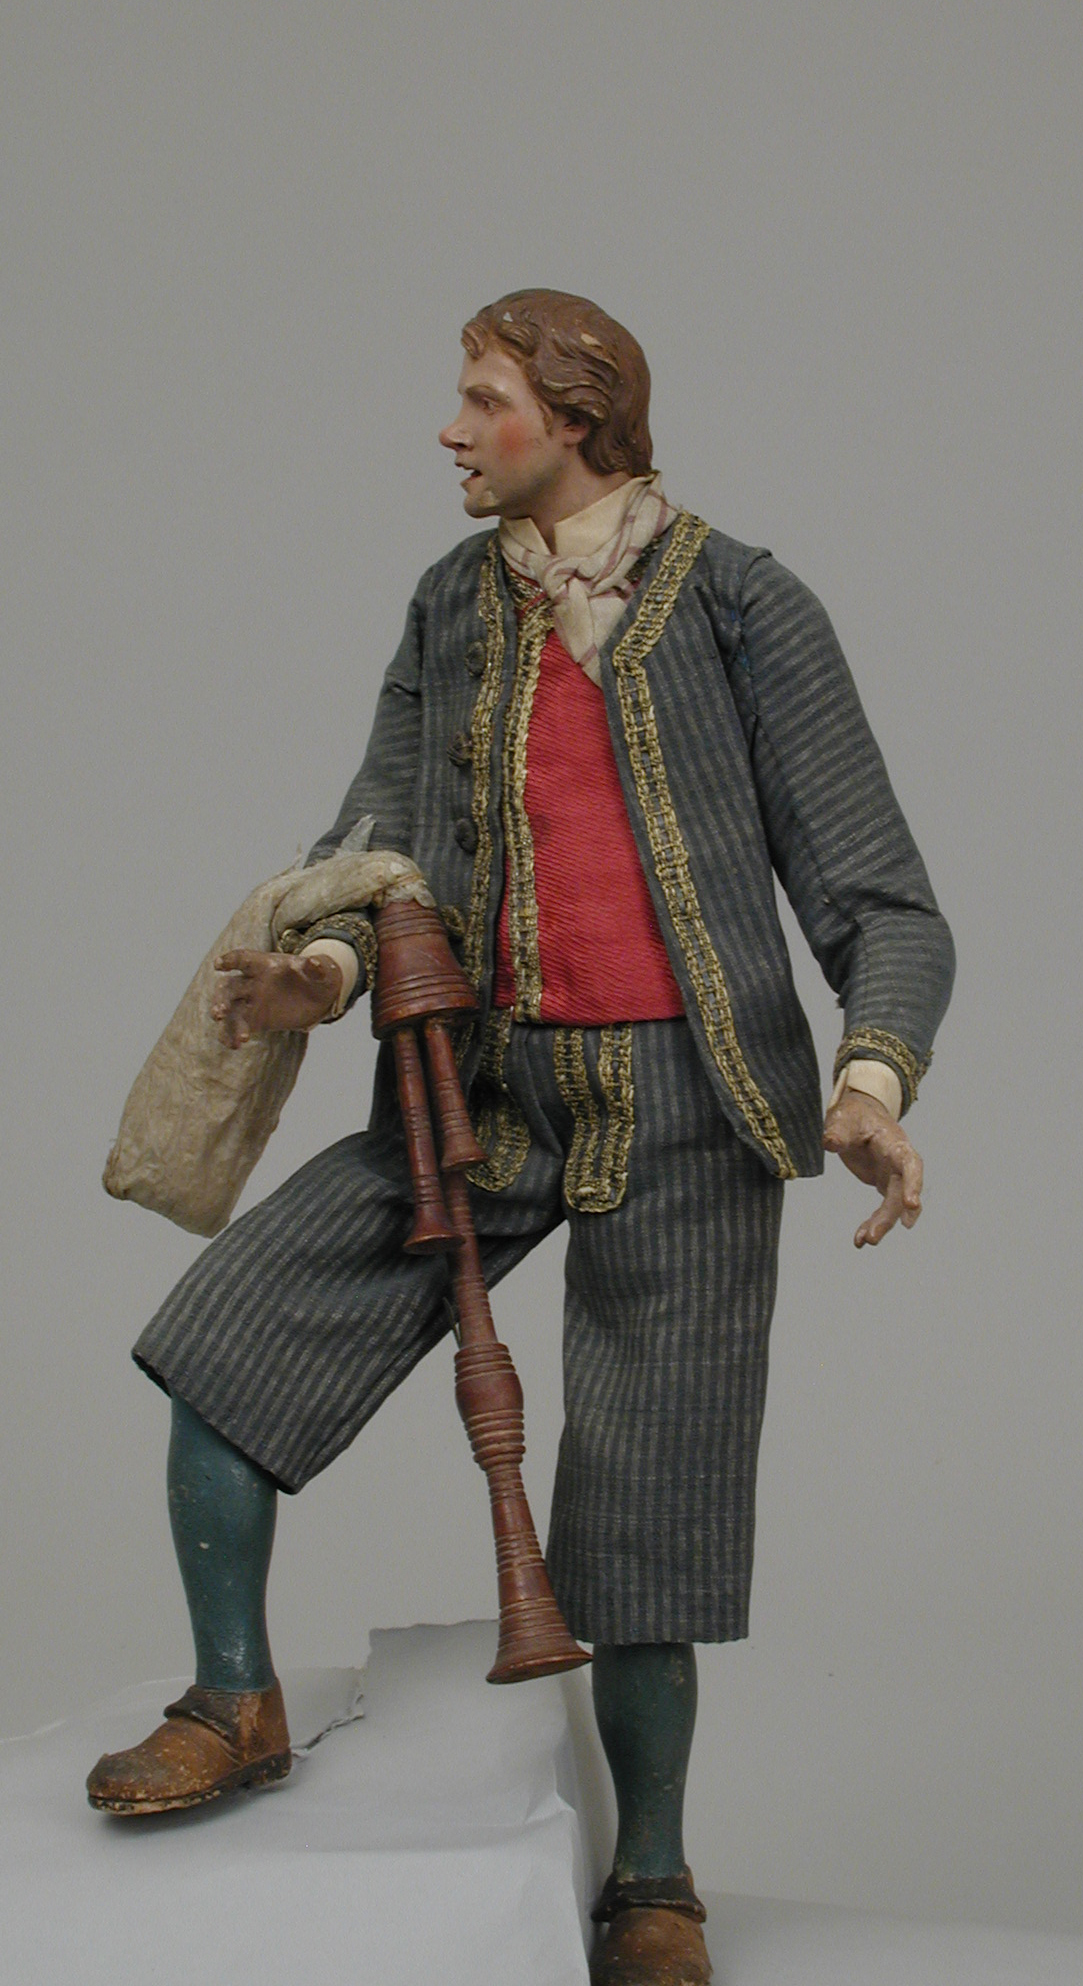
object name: crèche figure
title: Young man in suit with bagpipes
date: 1767-1833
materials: terracotta, fiber, metal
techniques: polychrome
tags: men,bagpipes